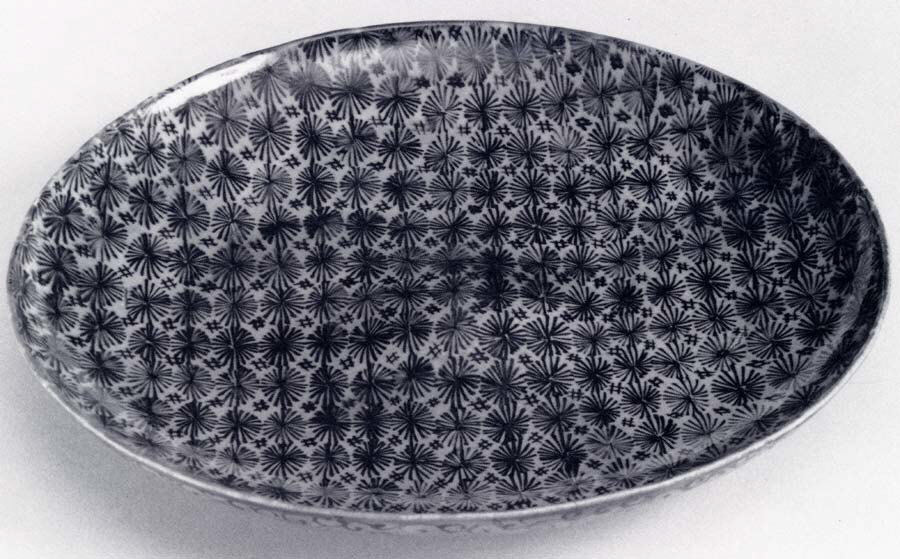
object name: plate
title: Plate with Design of Pine Needles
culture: japanese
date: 1650-1659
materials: enamel, porcelain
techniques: overglaze